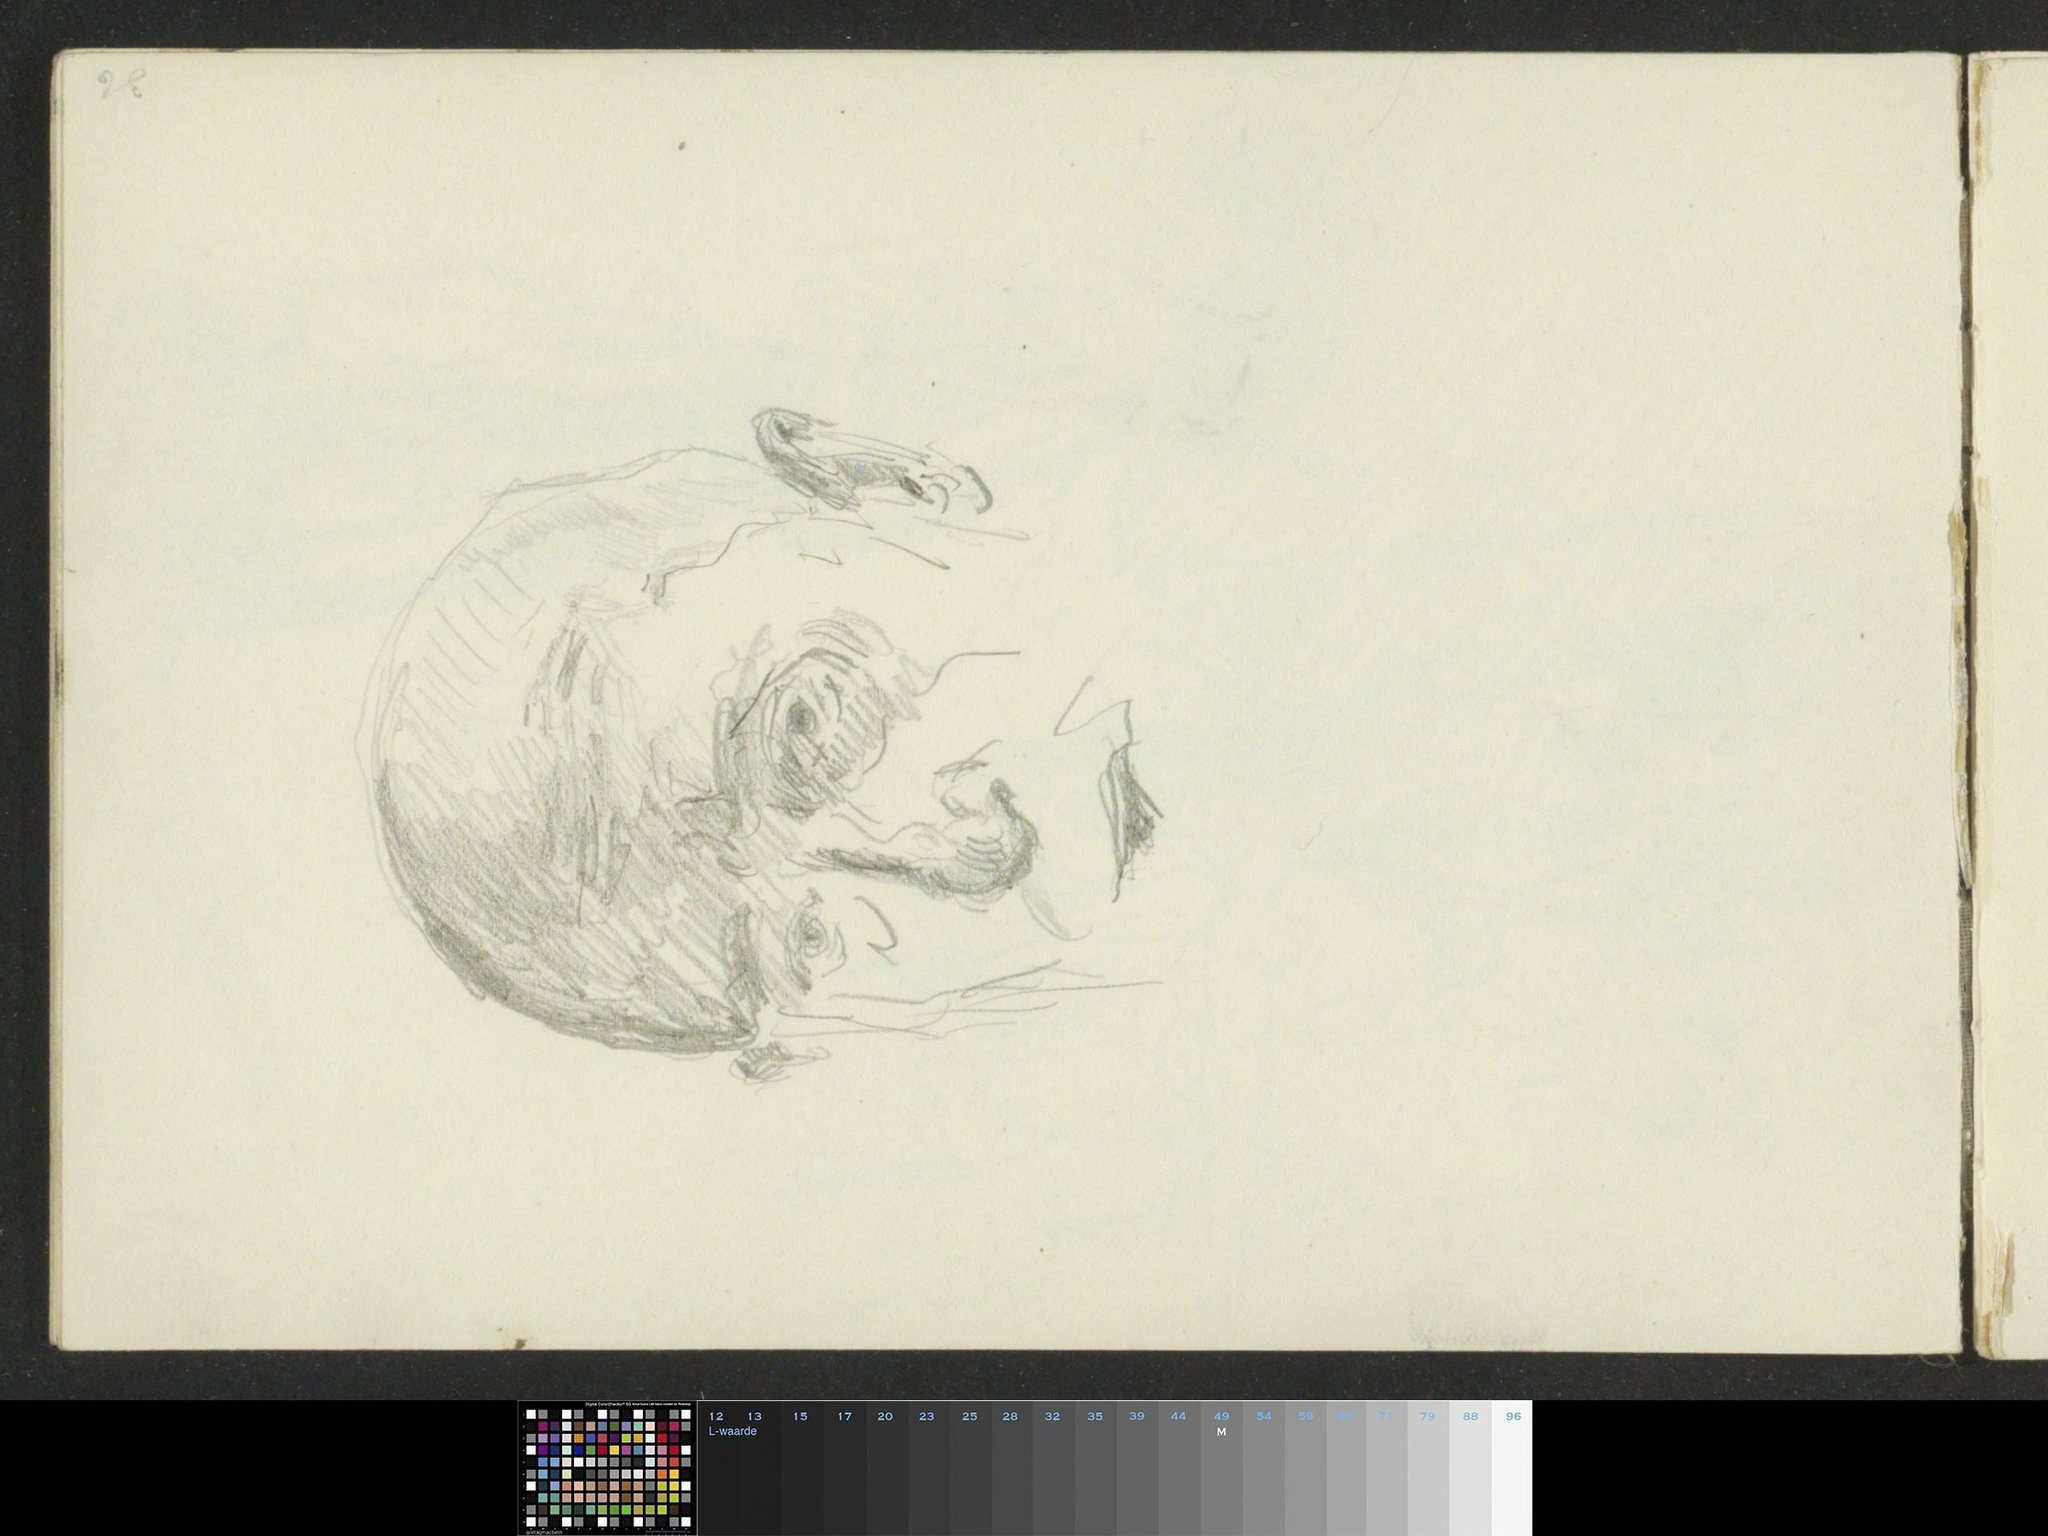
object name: sketchbook leaf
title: Zelfportret van Isaac Israels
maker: isaac israels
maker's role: draughtsman, painter, print maker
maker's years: 1865-1934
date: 1875-1934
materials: paper, pencil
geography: the hague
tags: portrait, self-portrait of artist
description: Blad 5 verso uit schetsboek LXI met 20 bladen.